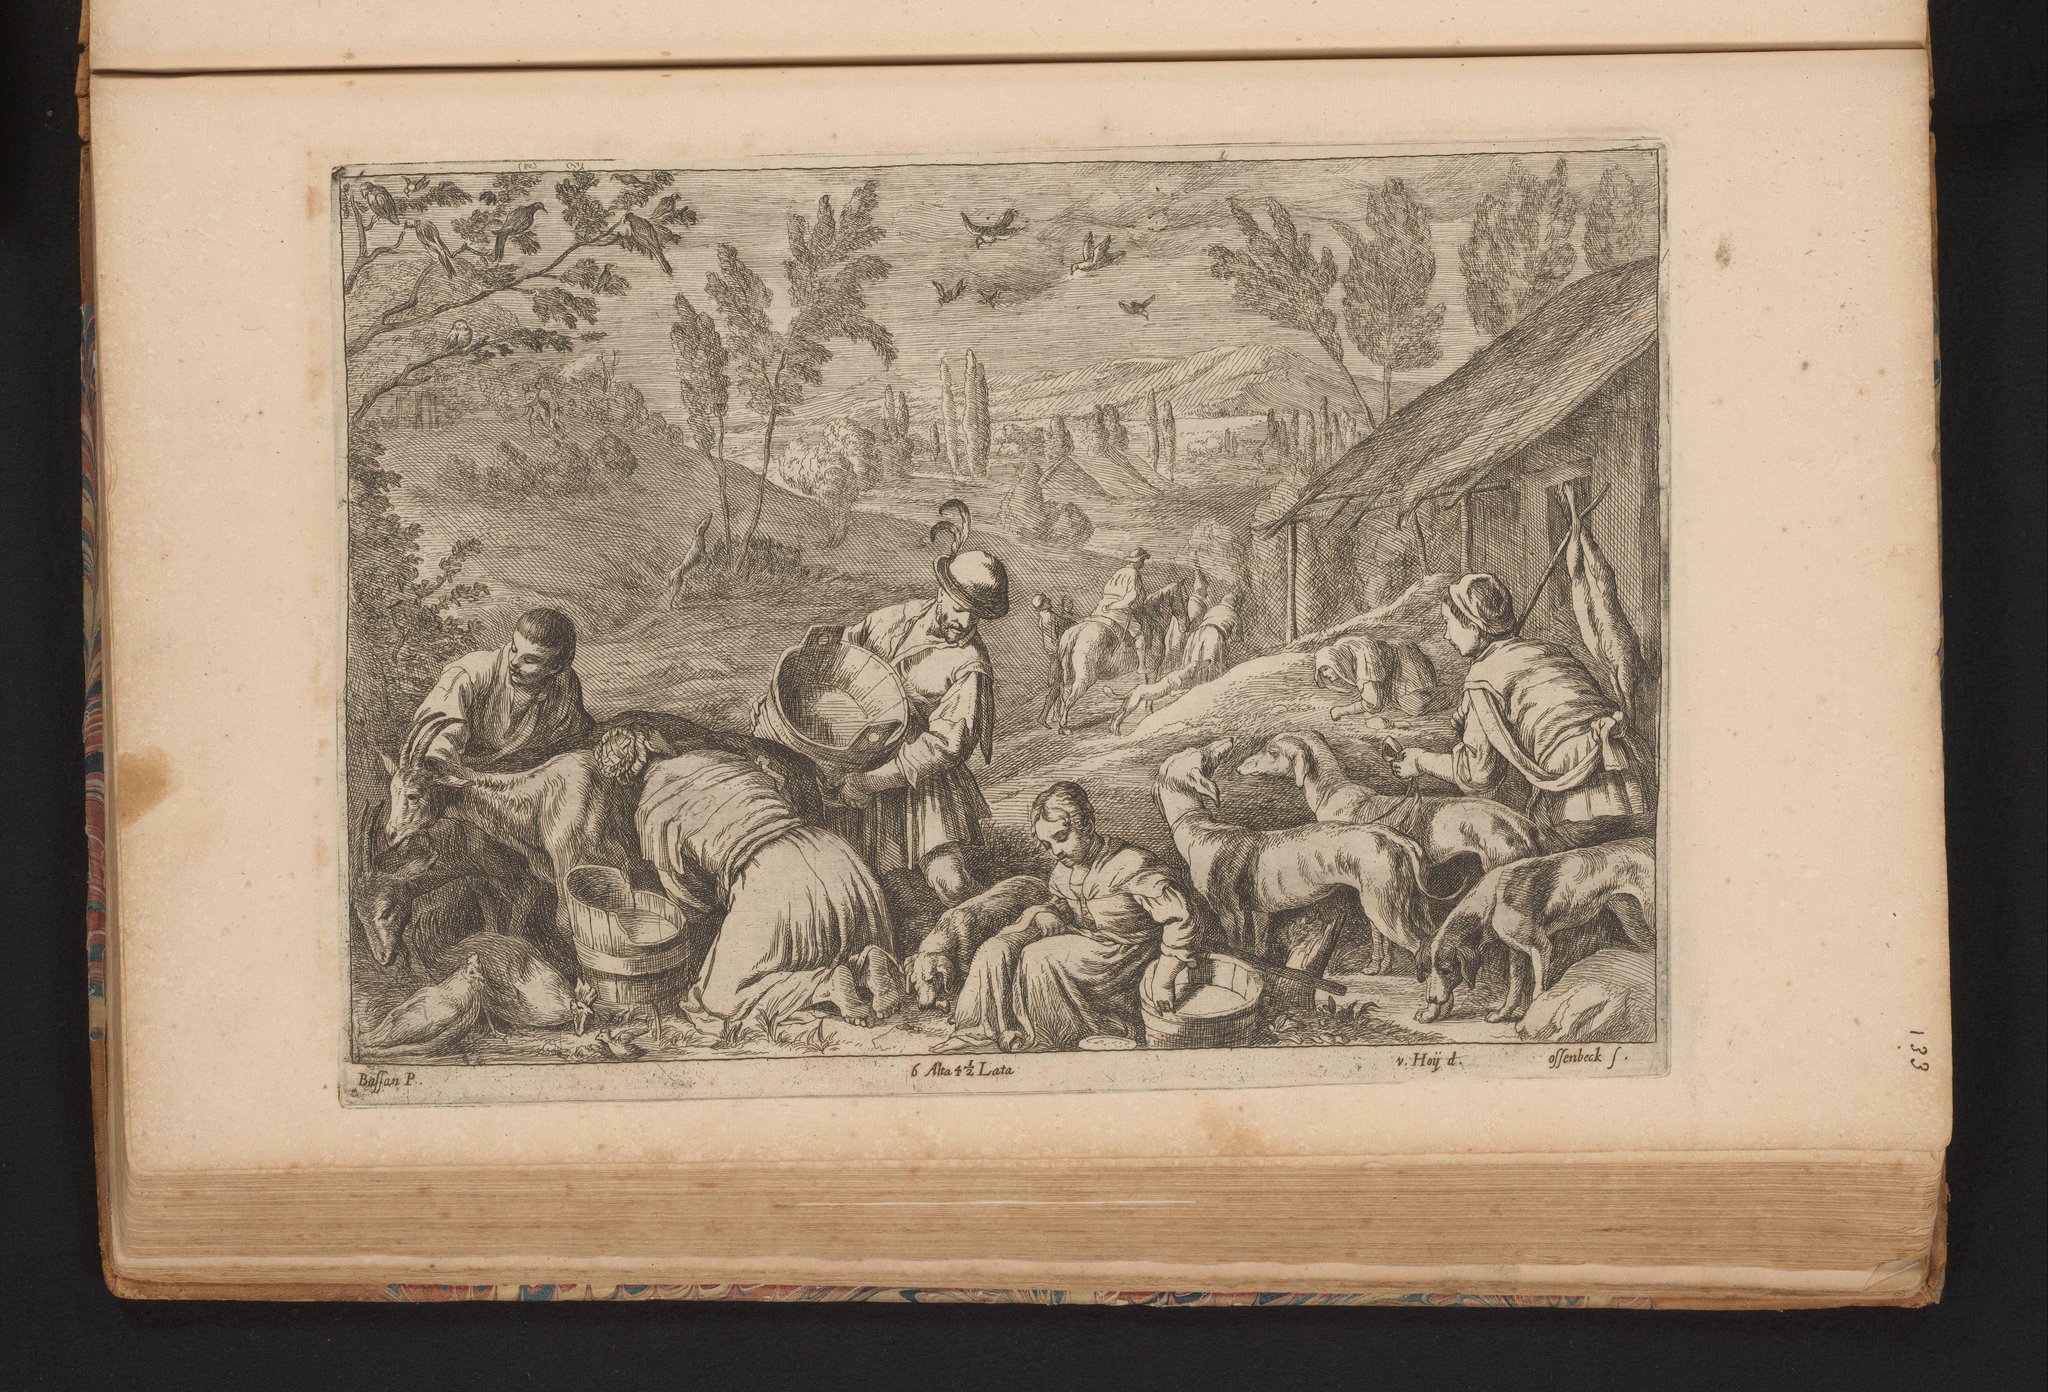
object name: print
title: Lente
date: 1660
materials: paper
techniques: etching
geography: brussels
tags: spring ~ human activities (the four seasons of the year) (+ with scenes showing human occupations ~ seasons and months), expulsion of adam and eve from paradise (genesis 3:22-24), milking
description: De prent is vervaardigd naar het schilderij van Bassano dat zich in de collectie van het Kunsthistorisches Museum te Wenen bevindt (inventarisnummer GG_4303). David Teniers heeft waarschijnlijk van alle schilderijen uit de collectie van Leopold Willem van Oostenrijk een olieverfstudie op doek of paneel vervaardigd (zgn. pasticcio), die als voorbeeld voor de prentmakers diende. Het is niet altijd duidelijk of de pasticci door hem zijn gemaakt of door zijn atelier. Niet alle pasticci zijn overgeleverd.